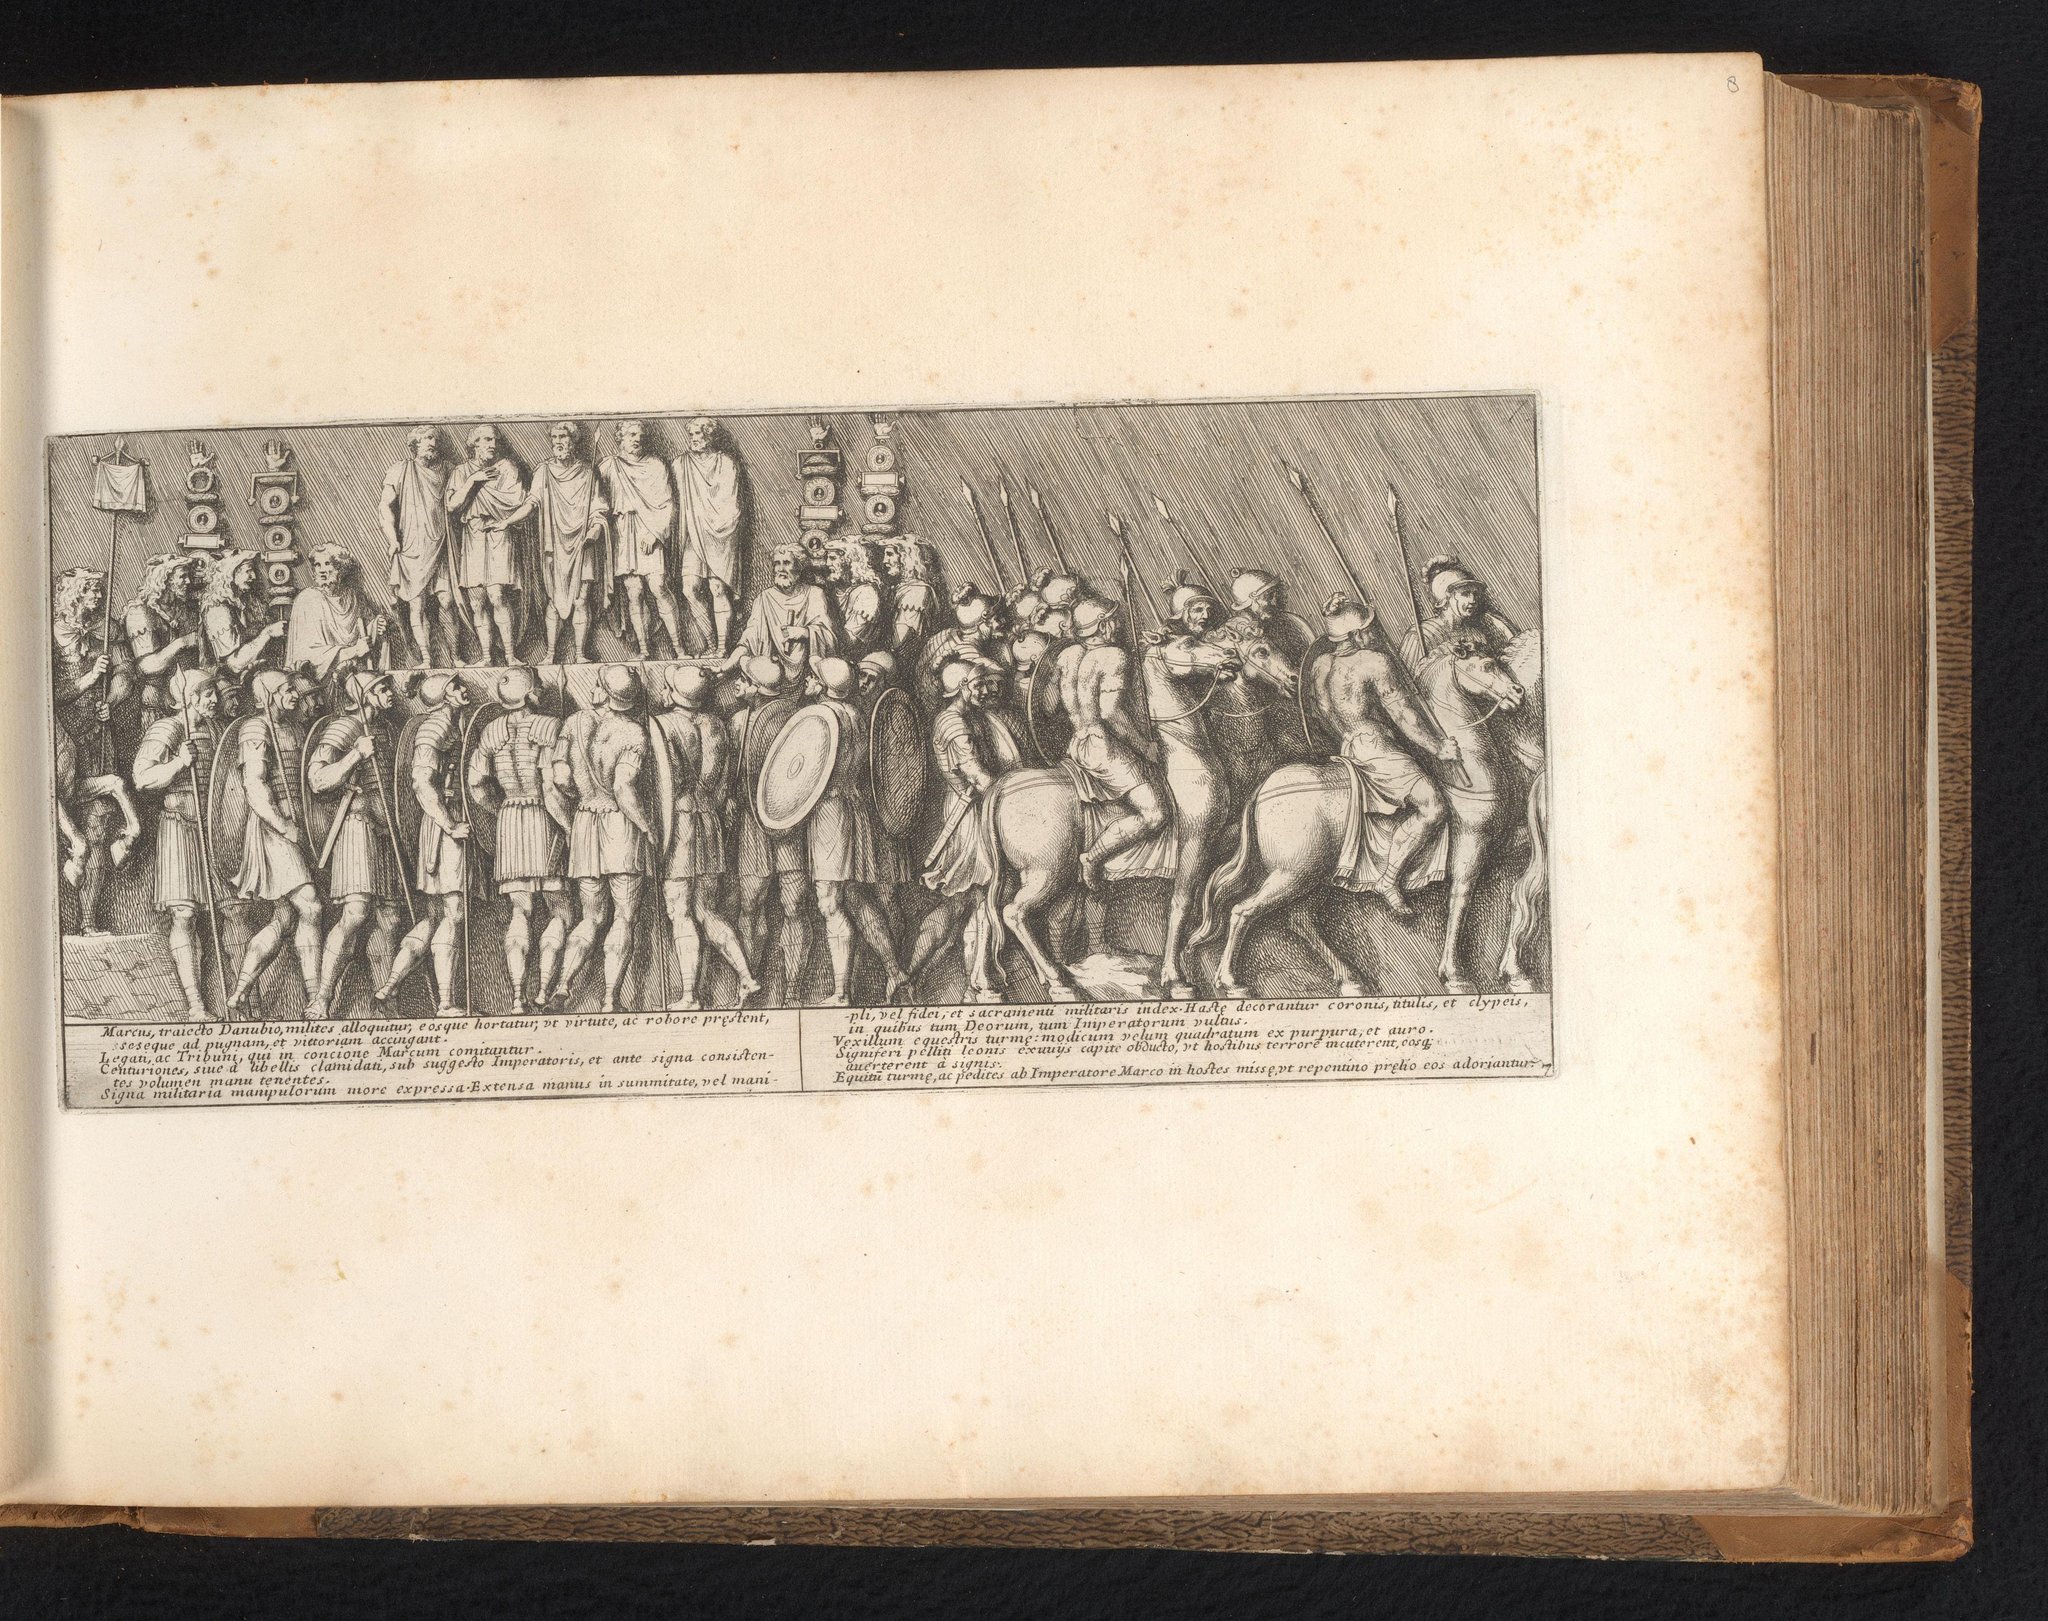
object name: album leaf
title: Zuil van Marcus Aurelius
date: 1672-1675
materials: paper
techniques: etching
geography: rome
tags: triumphal column with helical friezes, piece of sculpture, reproduction of a piece of sculpture, the soldier; the soldier's life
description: Detail van het spiraalvormige gebeeldhouwde fries op de Zuil van Marcus Aurelius te Rome. Het fries toont de oorlog tussen het Romeinse leger van keizer Marcus Aurelius en de Germaanse stammen der Marcomannen en Quaden en de oorlog tegen de Sarmaten die vanuit het huidige Iran Hongarije waren binnengevallen. Tekst in de ondermarge. Prent maakt deel uit van een album.